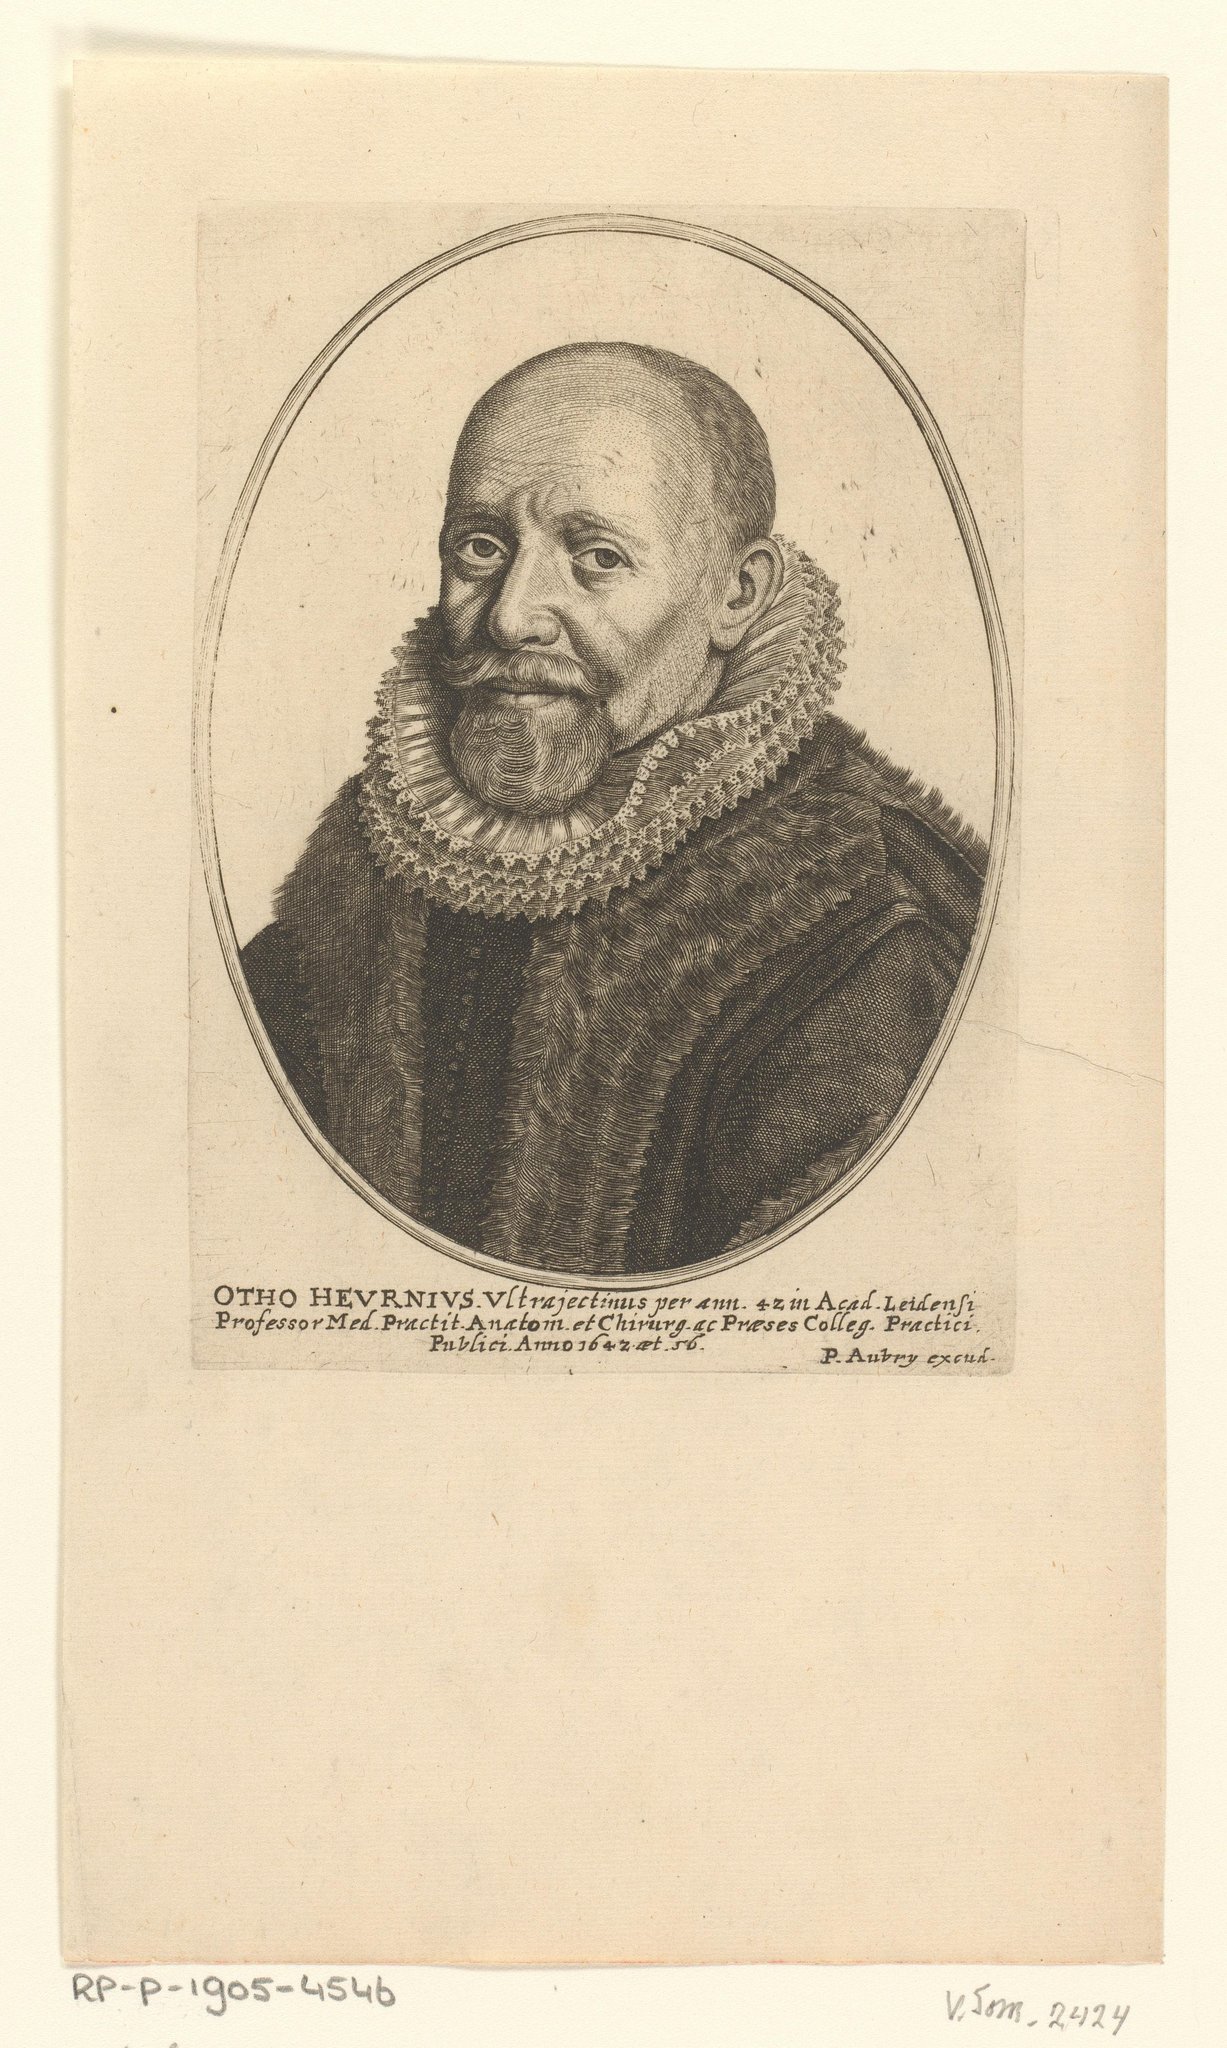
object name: print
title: Portret van Otto Heurnius op 56-jarige leeftijd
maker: crispijn van de passe (i)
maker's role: draughtsman, print maker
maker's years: 1564-1637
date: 1642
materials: paper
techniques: engraving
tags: otto heurnius, theologian, scholar, philosopher, historical persons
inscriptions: collector's mark: Lugt 2228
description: Met drieregelig onderschrift in het Latijn.